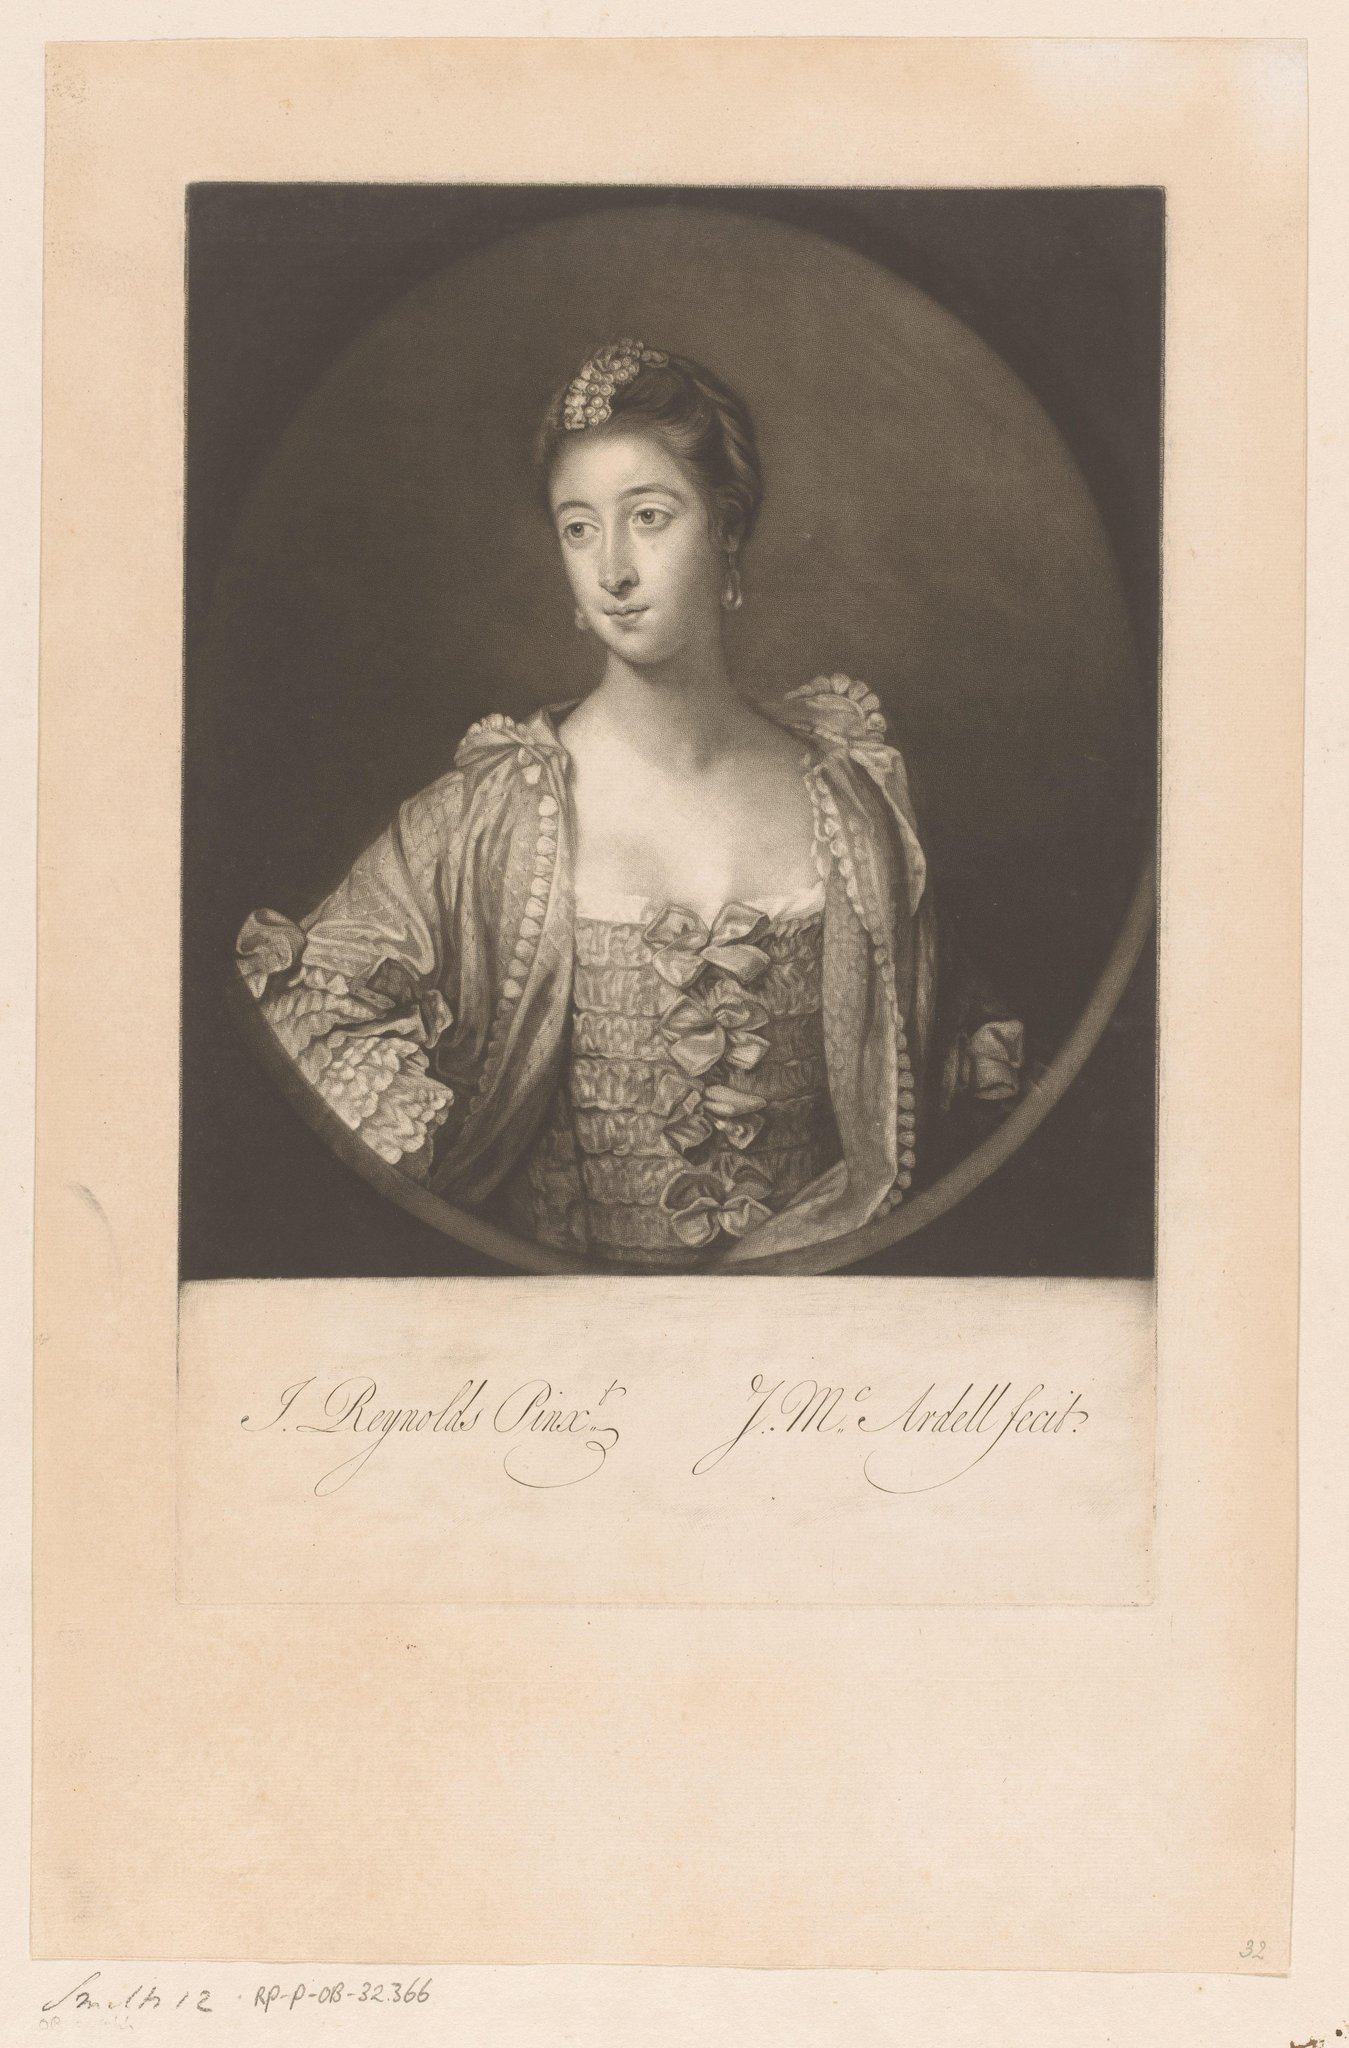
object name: print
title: Portret van Anne Bastard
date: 1742-1765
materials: paper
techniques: mezzotint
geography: london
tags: historical persons - bb - woman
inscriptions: collector's mark: Lugt 240